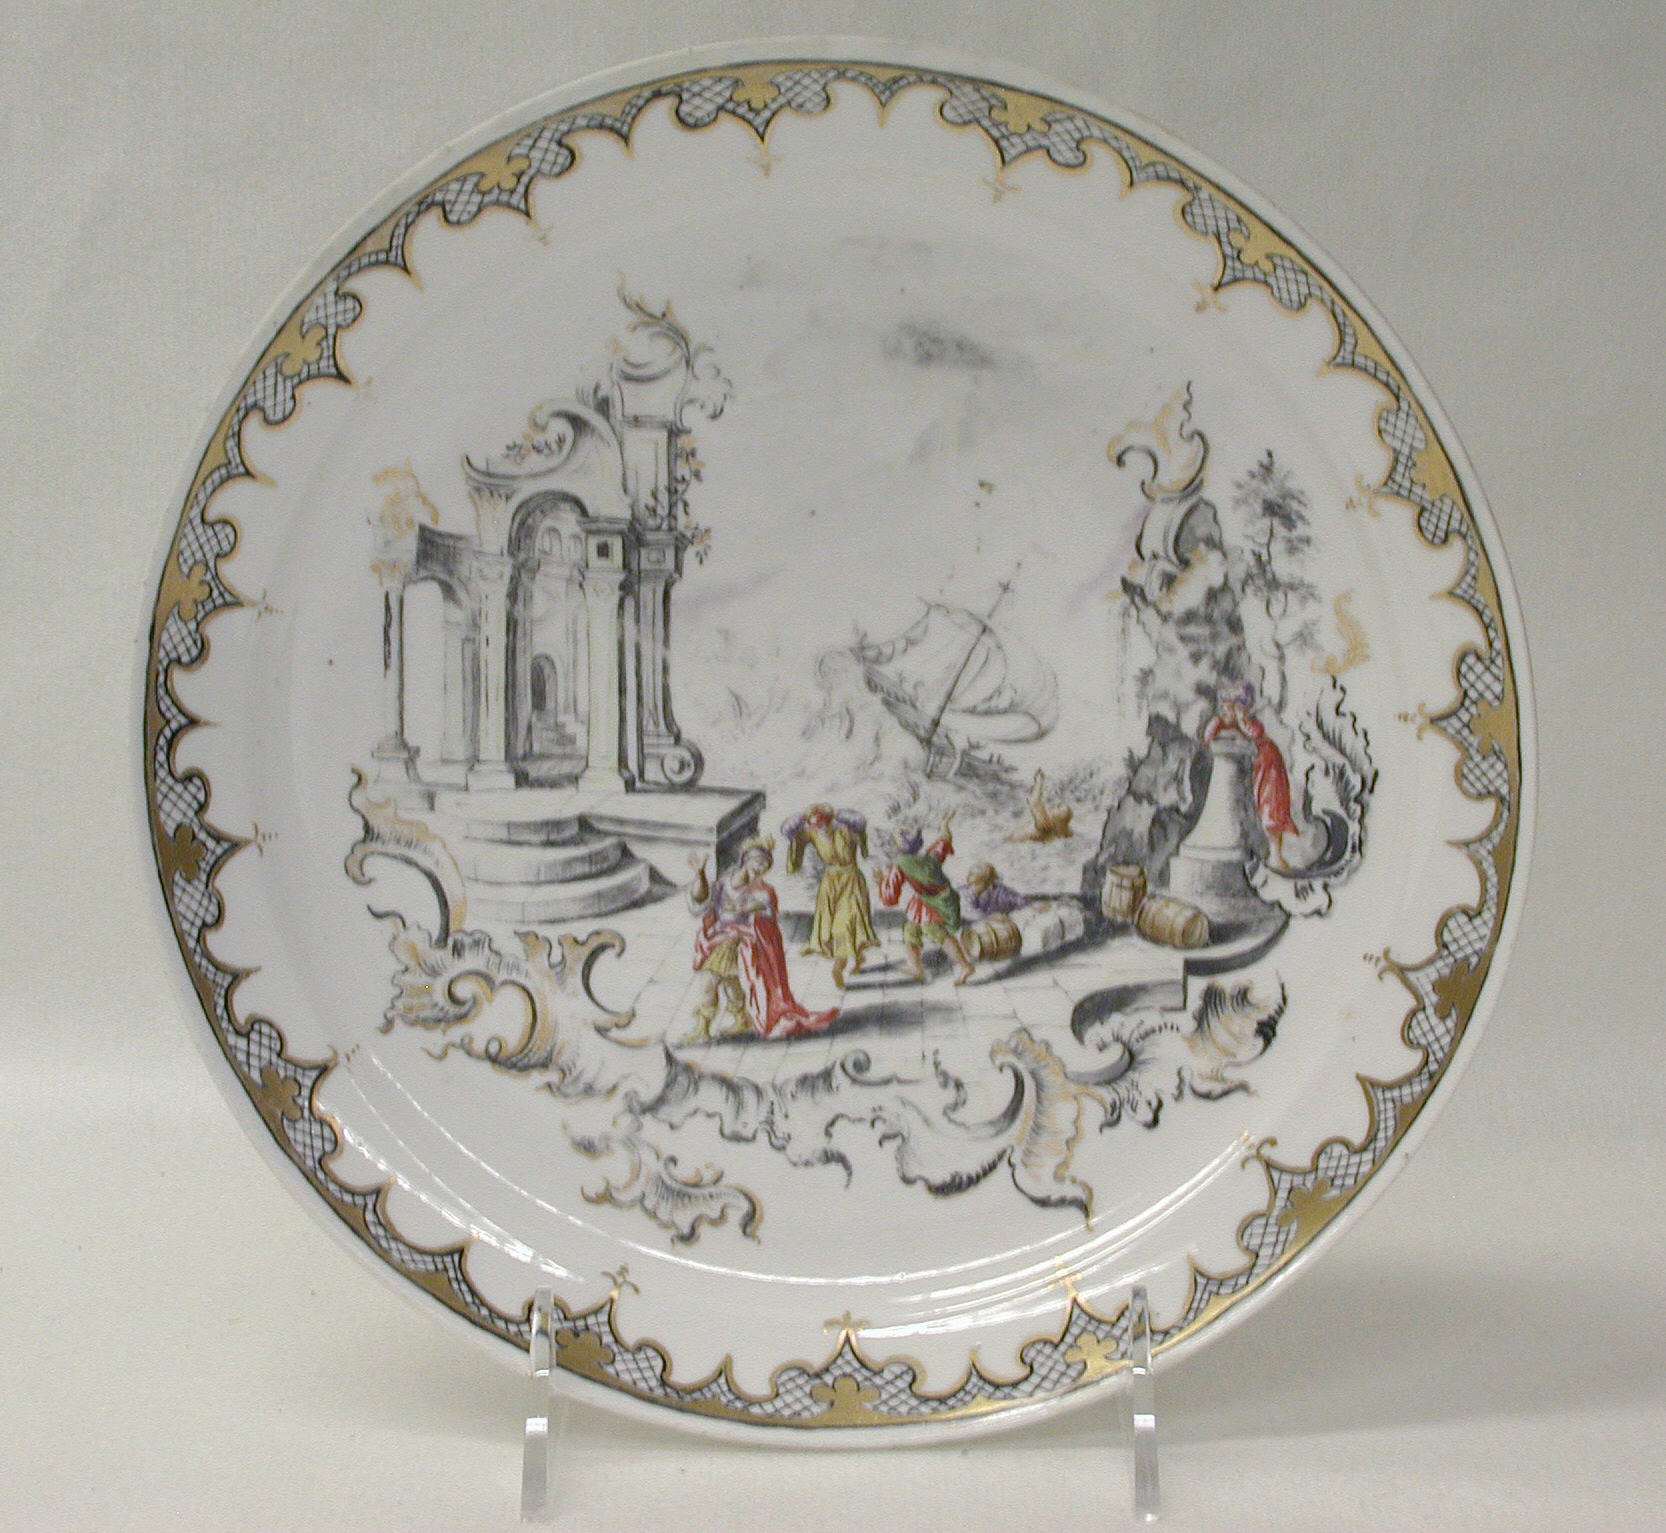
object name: plate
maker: nymphenburg porcelain manufactory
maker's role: manufactory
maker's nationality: german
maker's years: 1747-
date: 1760-1770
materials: hard paste porcelain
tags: human figures,ships